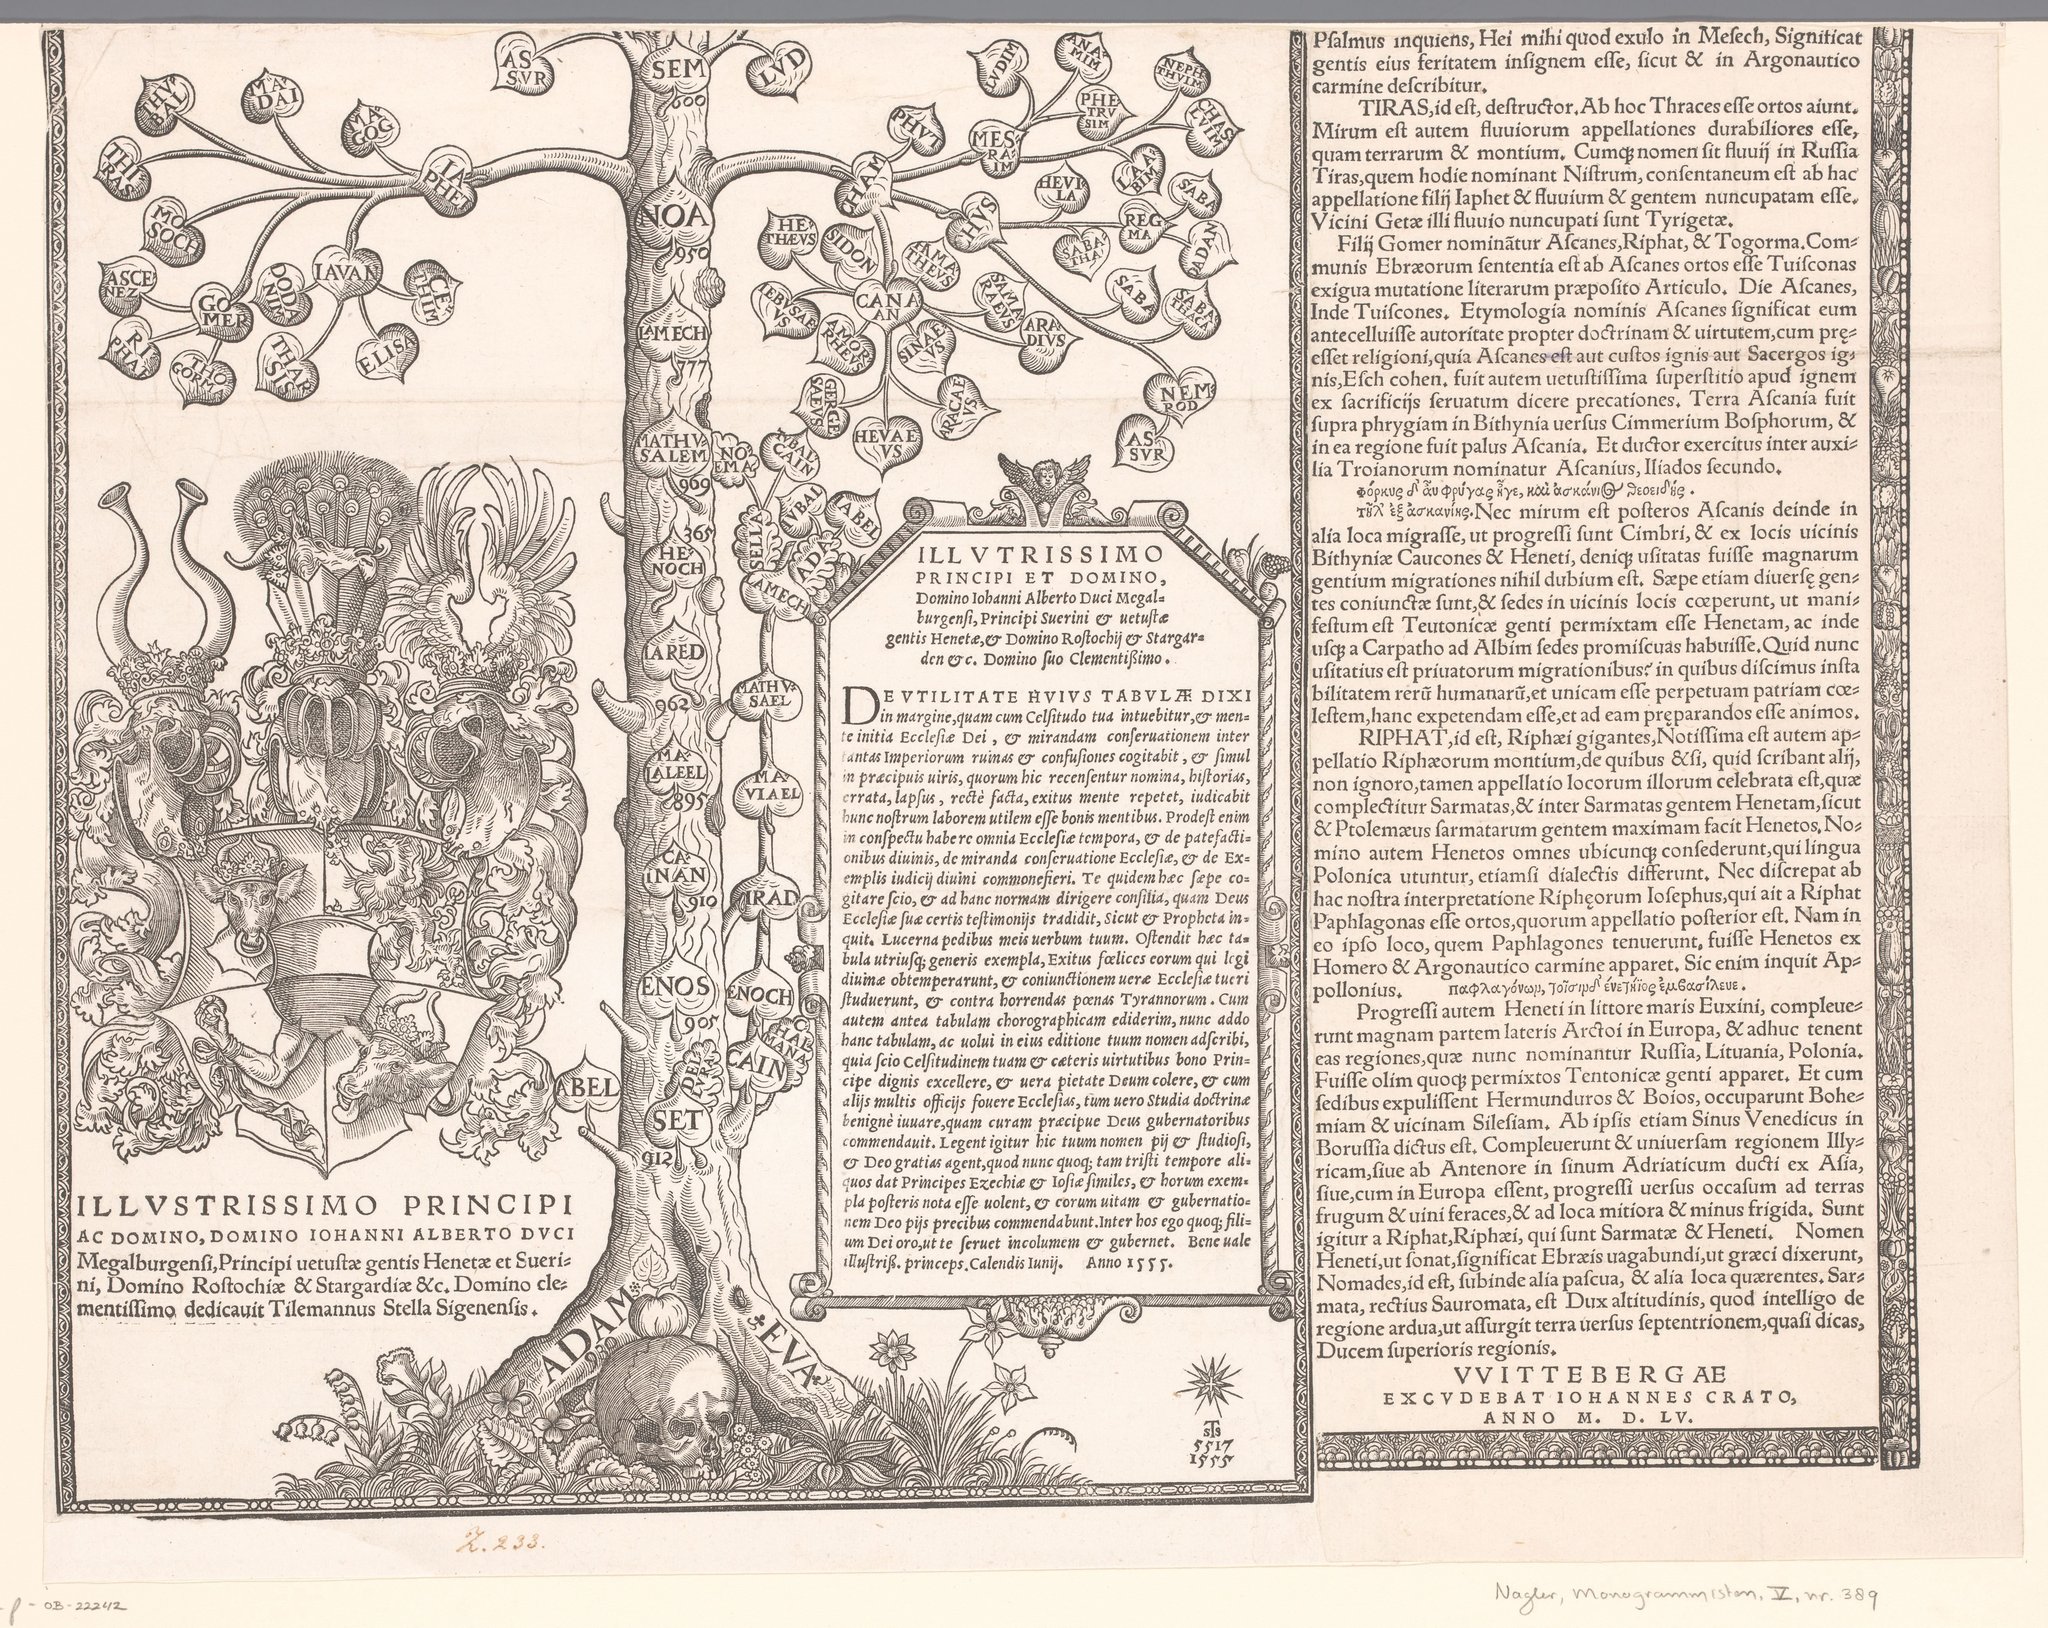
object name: print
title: Stamboom van Christus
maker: tillmann stella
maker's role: print maker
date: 1555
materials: paper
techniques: letterpress printing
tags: family lineage, pedigree, genealogical tree or table, christ, armorial bearing, heraldry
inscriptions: date